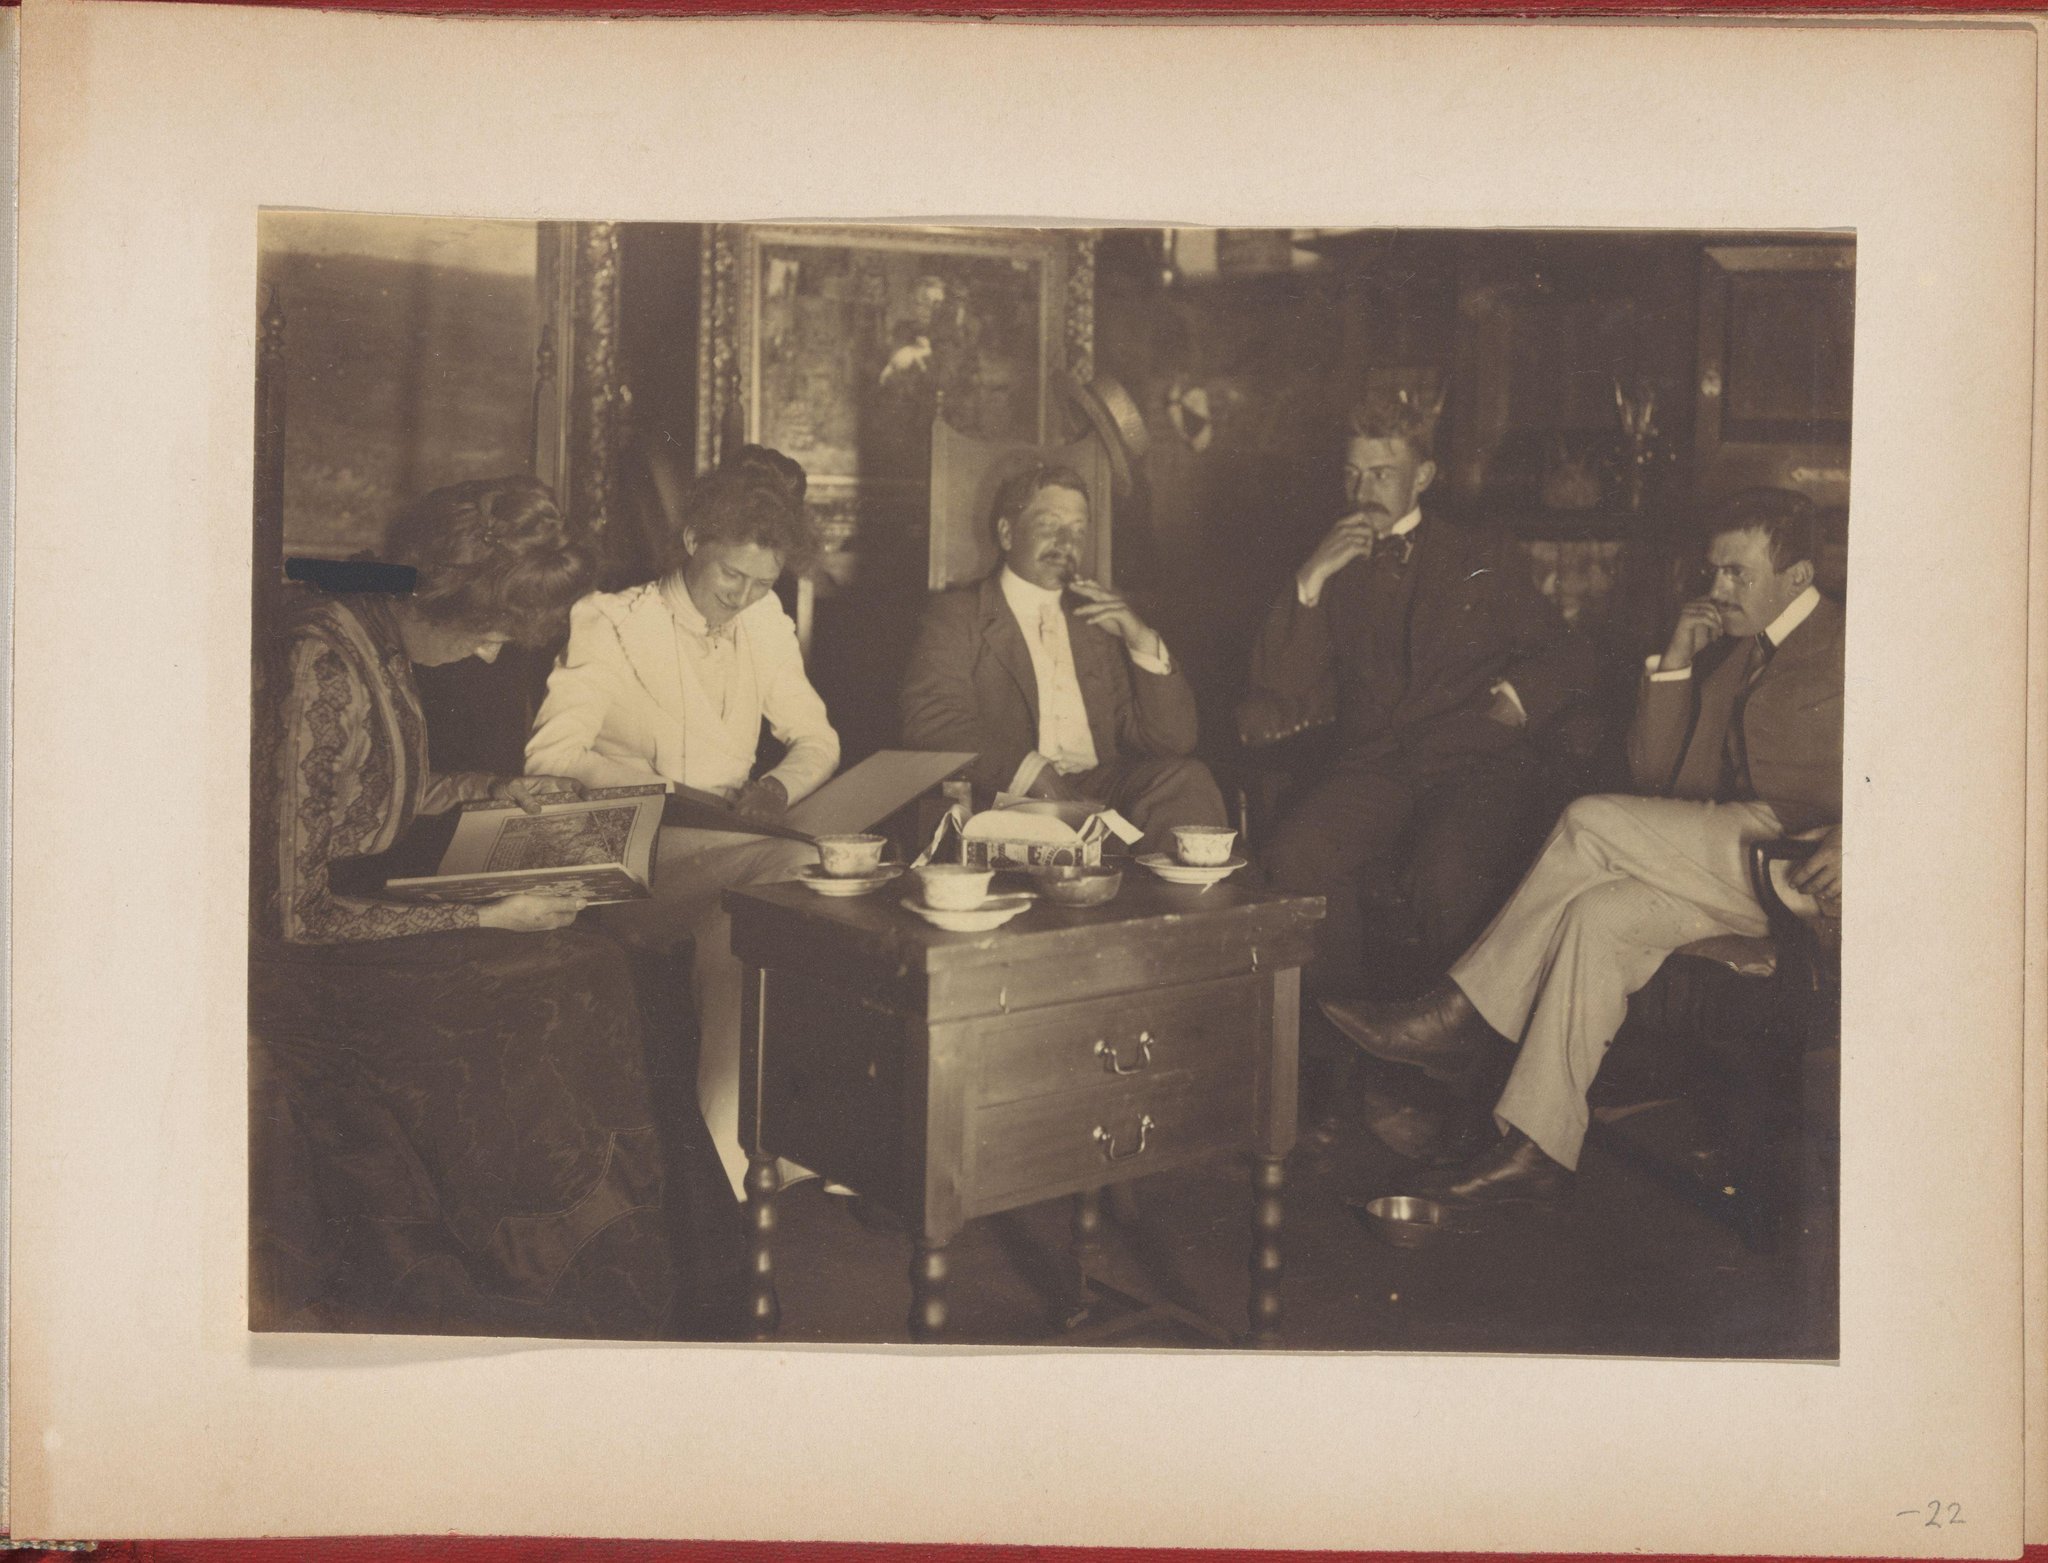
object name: photograph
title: Hedwig Kleintjes, Gerard Aalbersberg, Jan Kleintjes en een onbekende man en vrouw bekijken schetsboeken in het huis van Kleintjes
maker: gerard aalbersberg (us)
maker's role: amateurfotograaf, arts, chirurg, gynaecoloog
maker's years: 1870-1934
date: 1900-1906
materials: paper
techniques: photography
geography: heerde